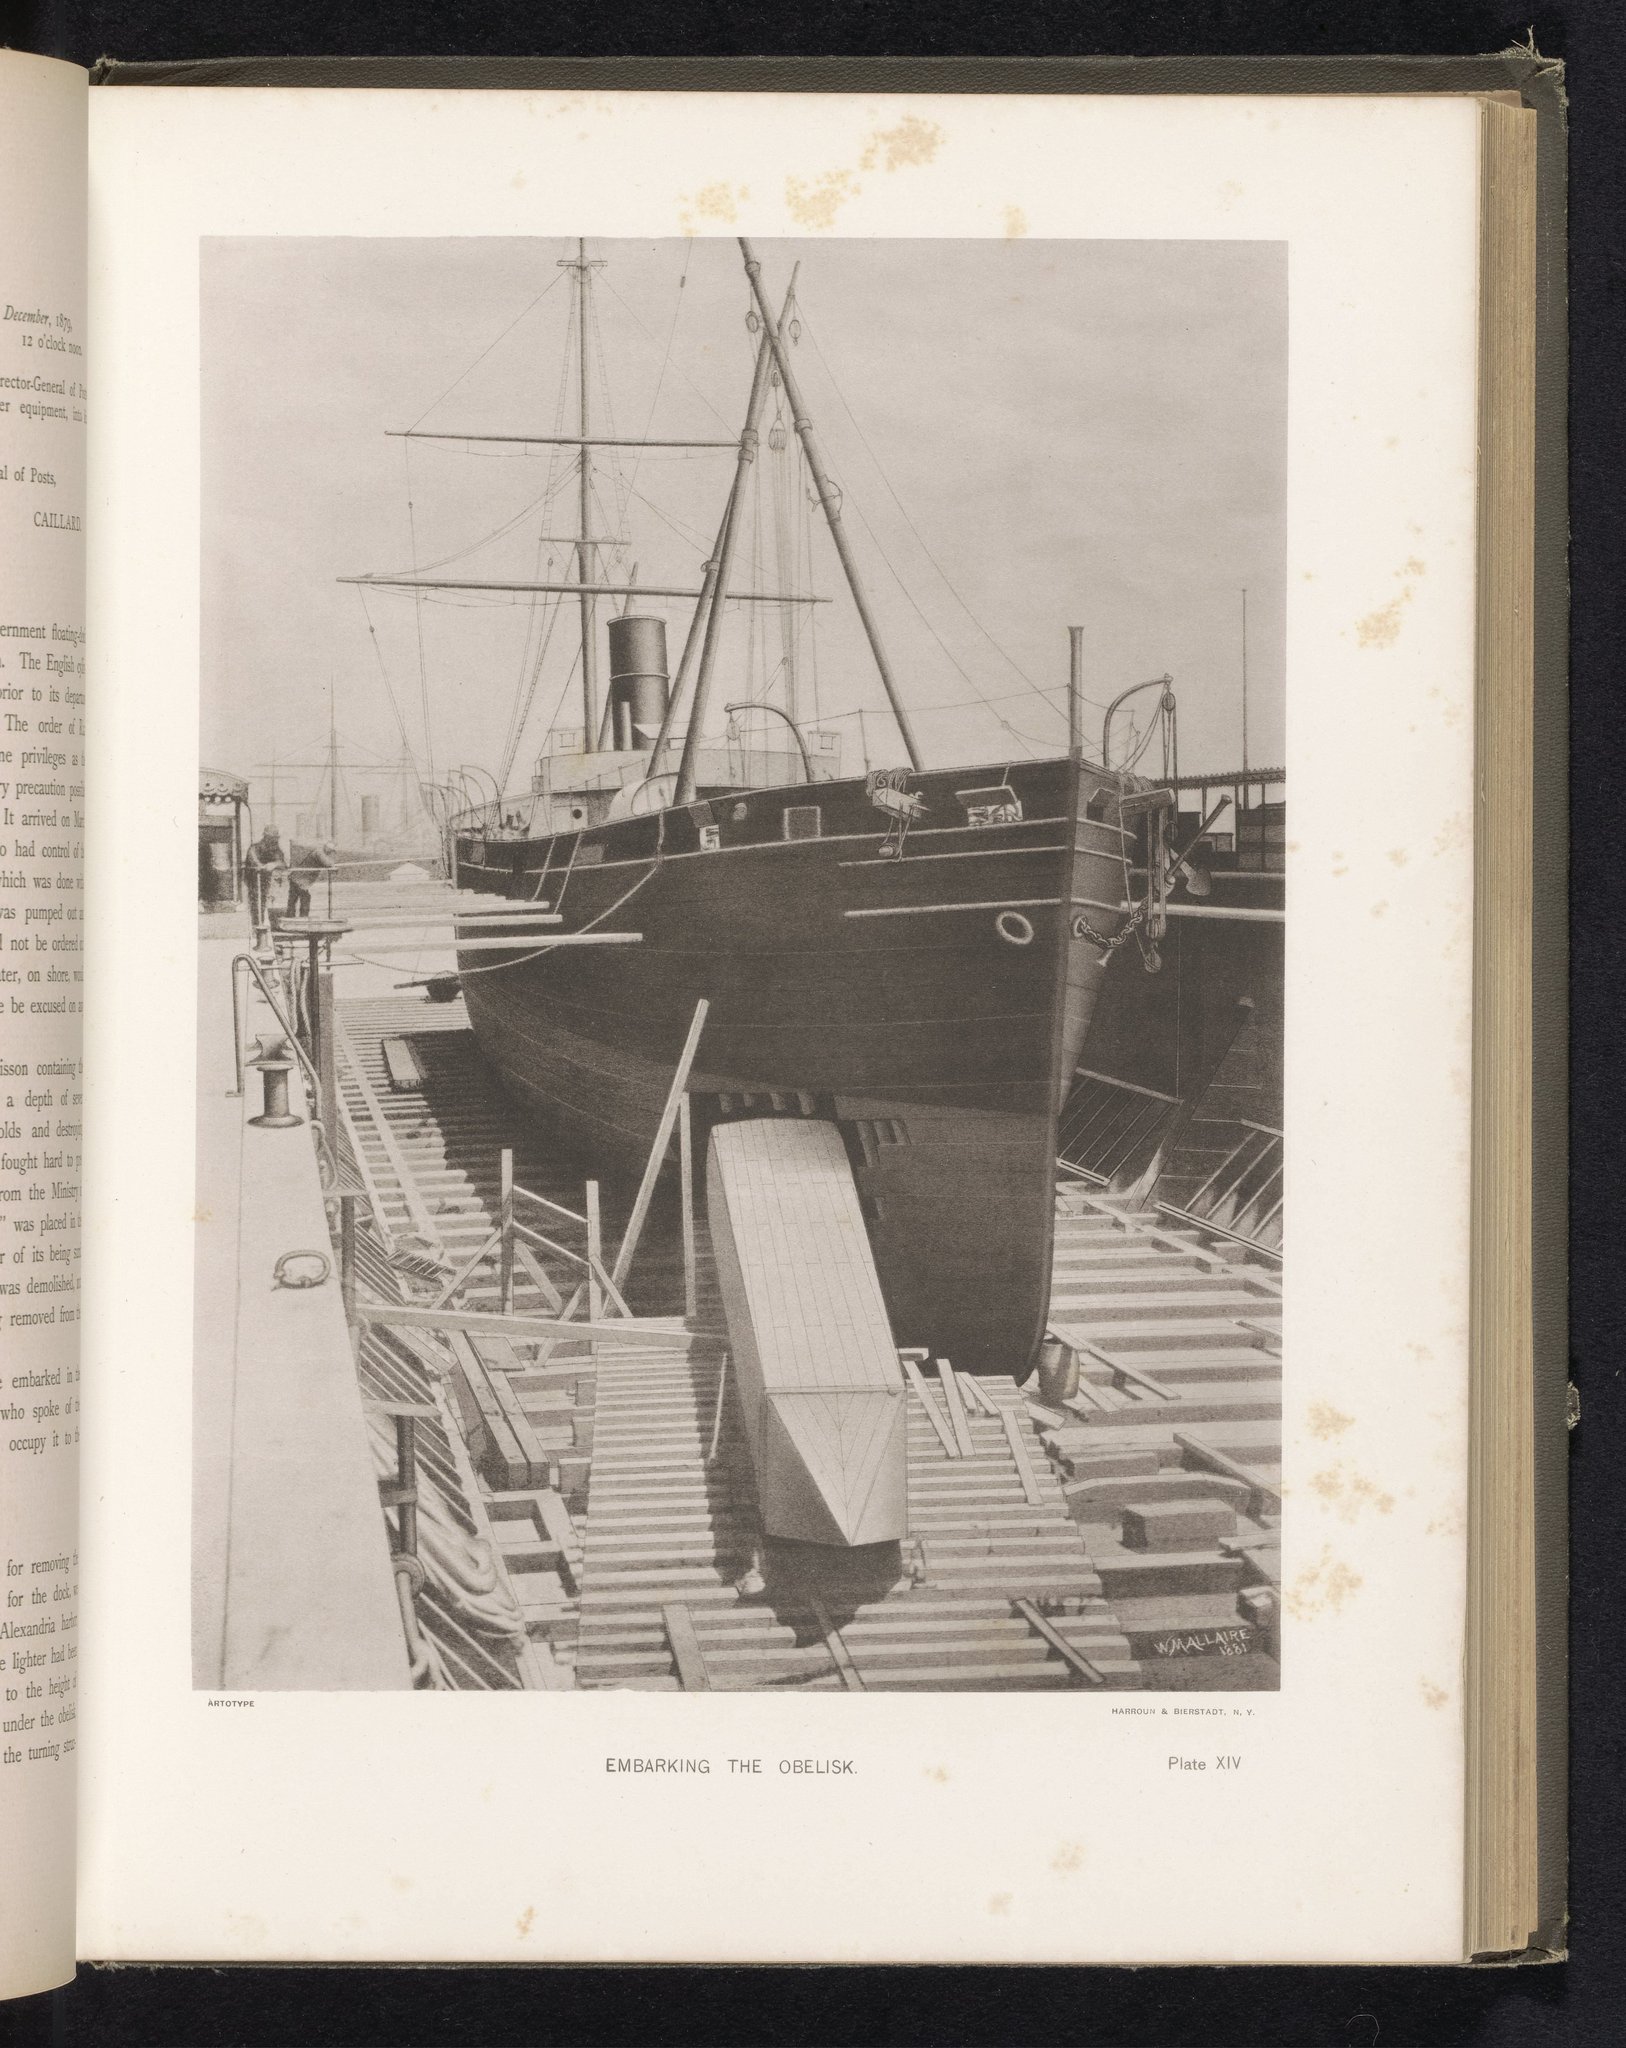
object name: page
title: Embarking the obelisk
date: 1881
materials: paper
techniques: photograph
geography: new york city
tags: obelisk, needle, ships (in general)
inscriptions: number: ‘Plate XIV’